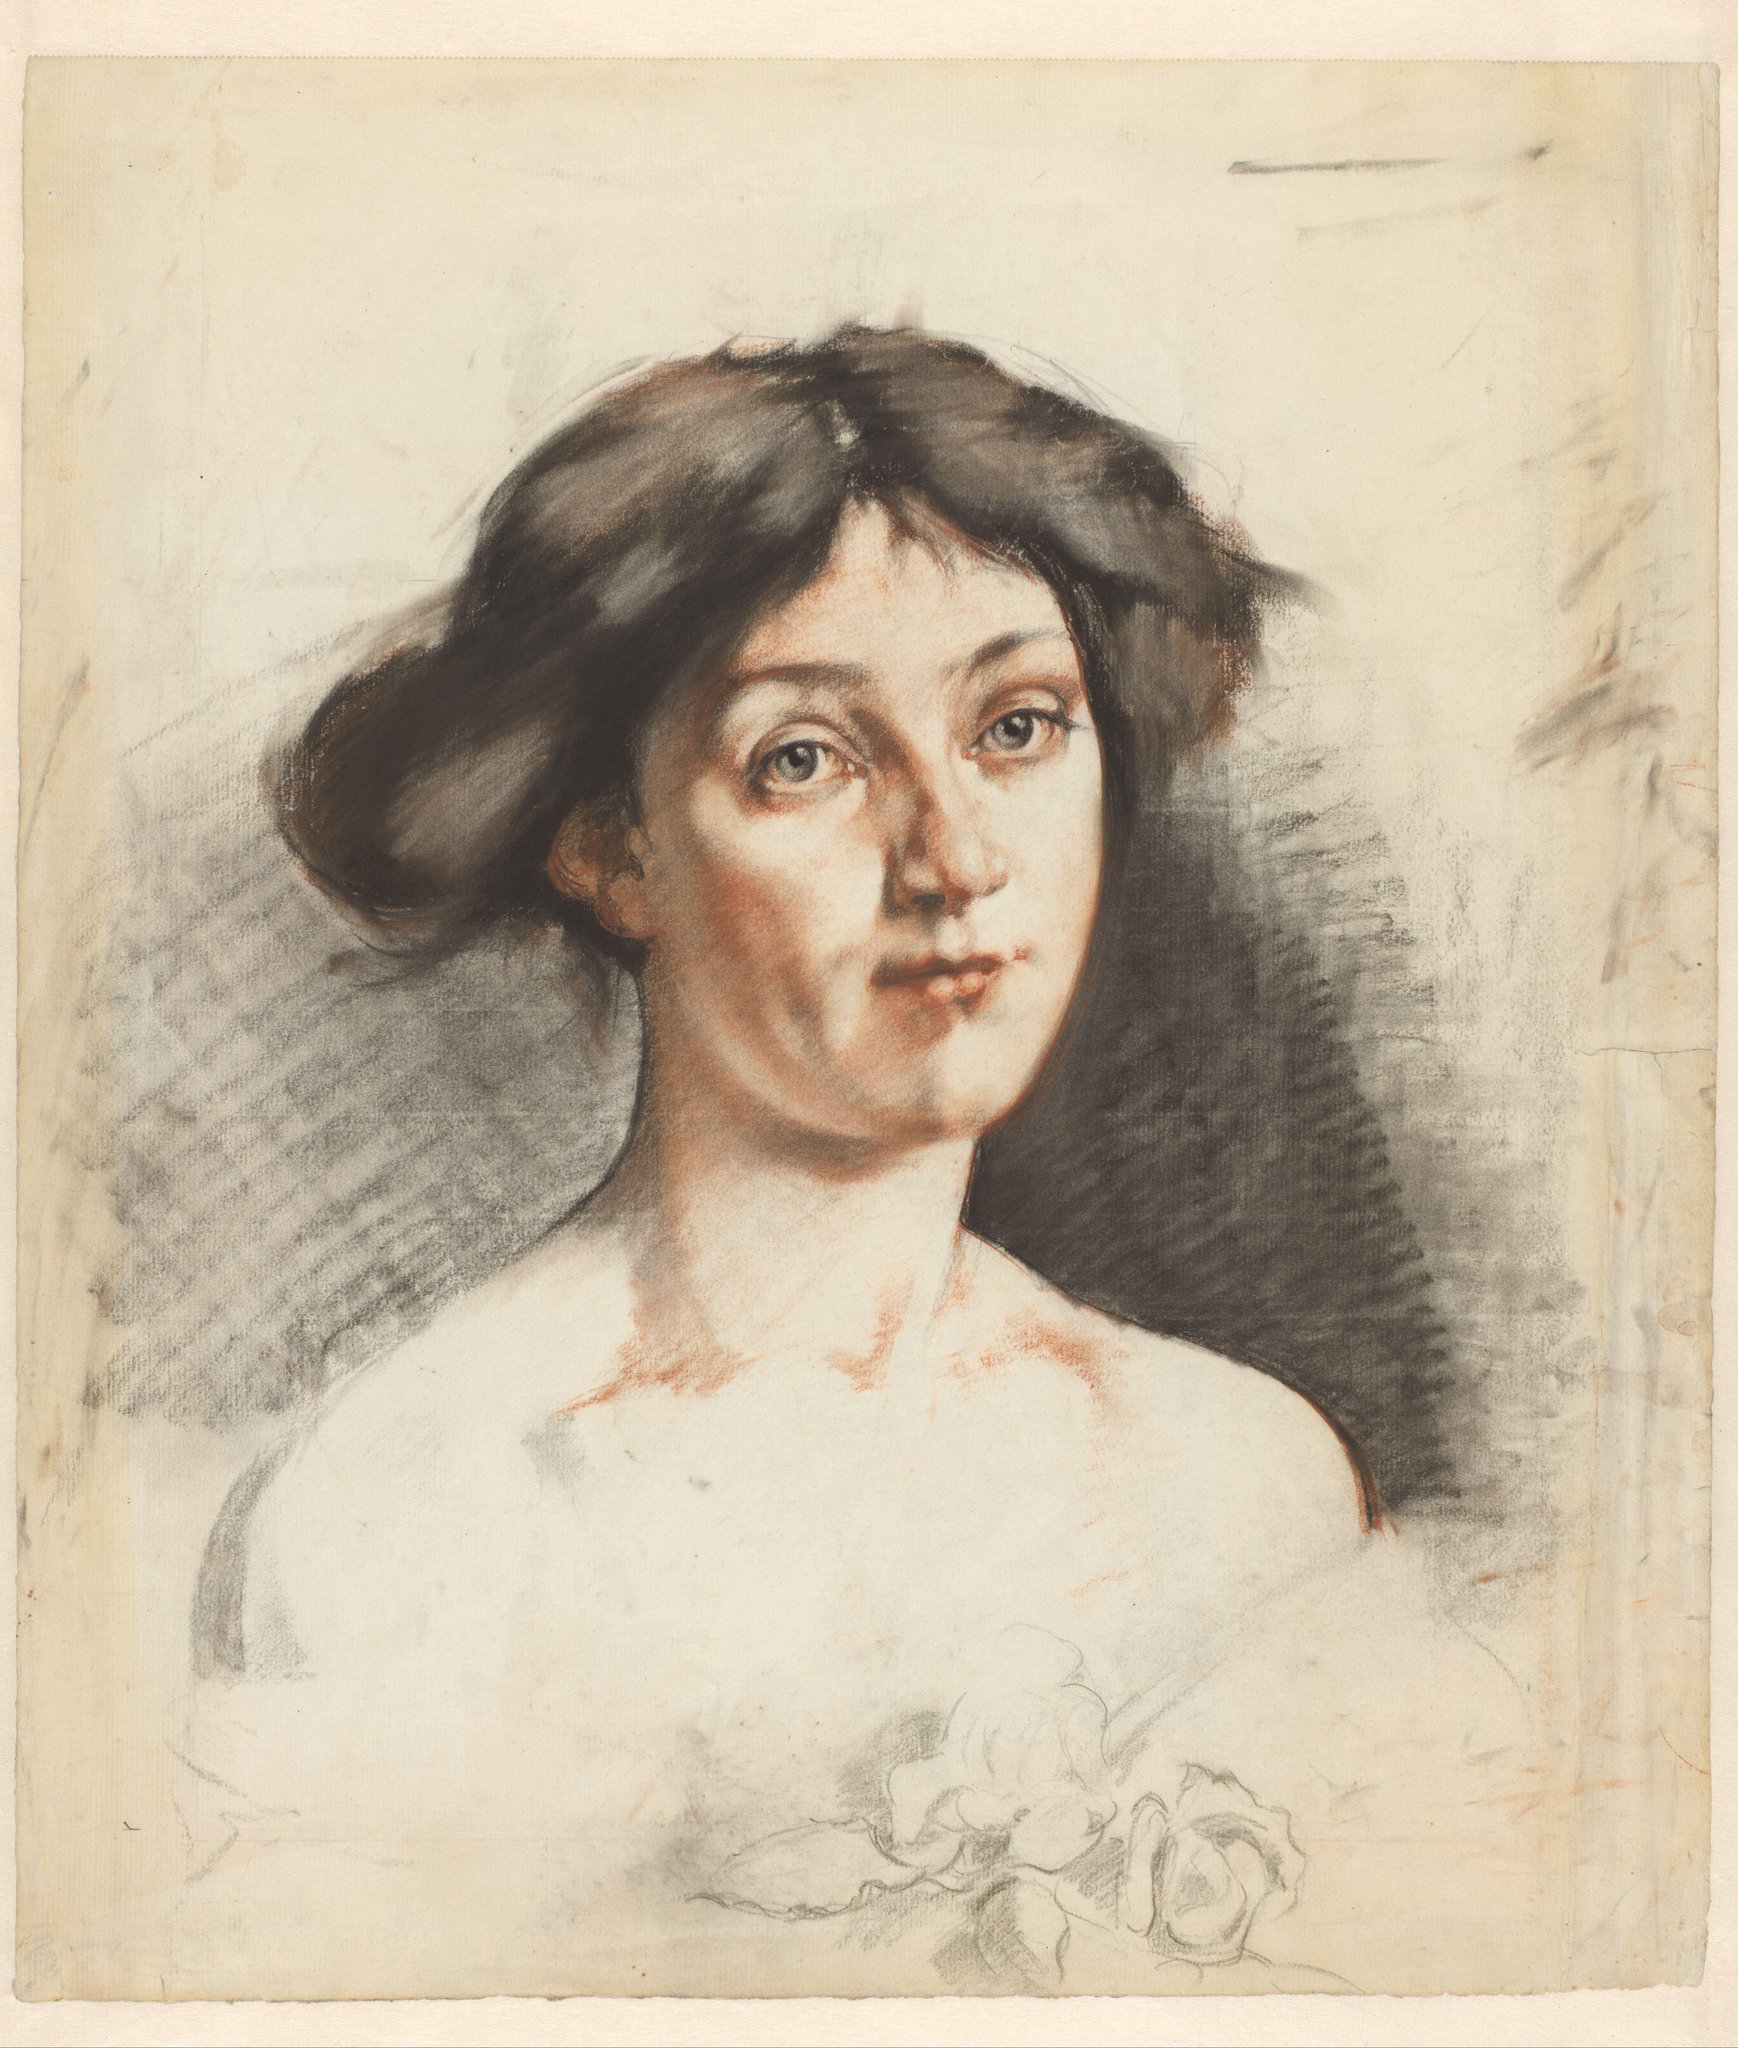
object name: drawing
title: Portret van Onny van Spingler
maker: willem witsen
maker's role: draughtsman, painter, print maker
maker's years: 1860-1923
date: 1916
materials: chalk, paper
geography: amsterdam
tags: historical persons - bb - woman, flowers: rose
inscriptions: label: ‘W.F. / T.27’, inscription: ‘Onny van Spengler 1916 / Witsen’